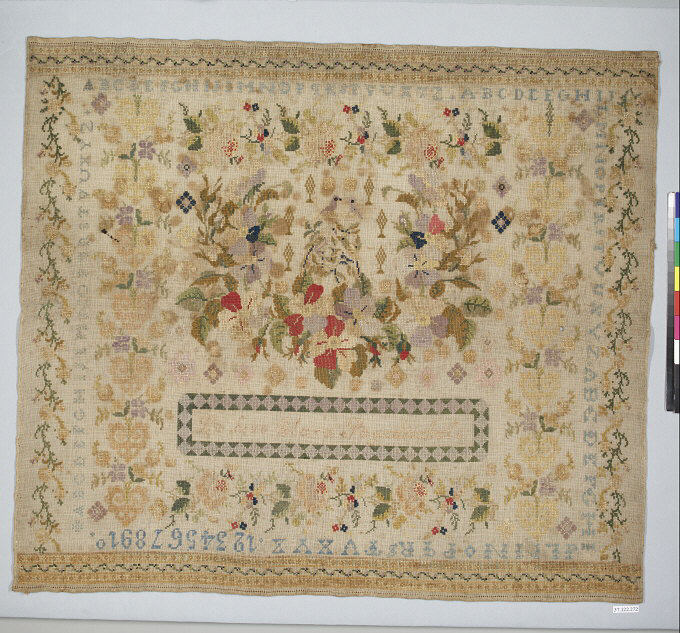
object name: sampler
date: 1801-1900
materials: canvas, silk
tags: flowers